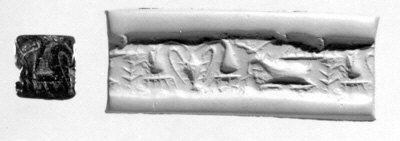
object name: cylinder seal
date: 3100-2900 BCE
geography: syria